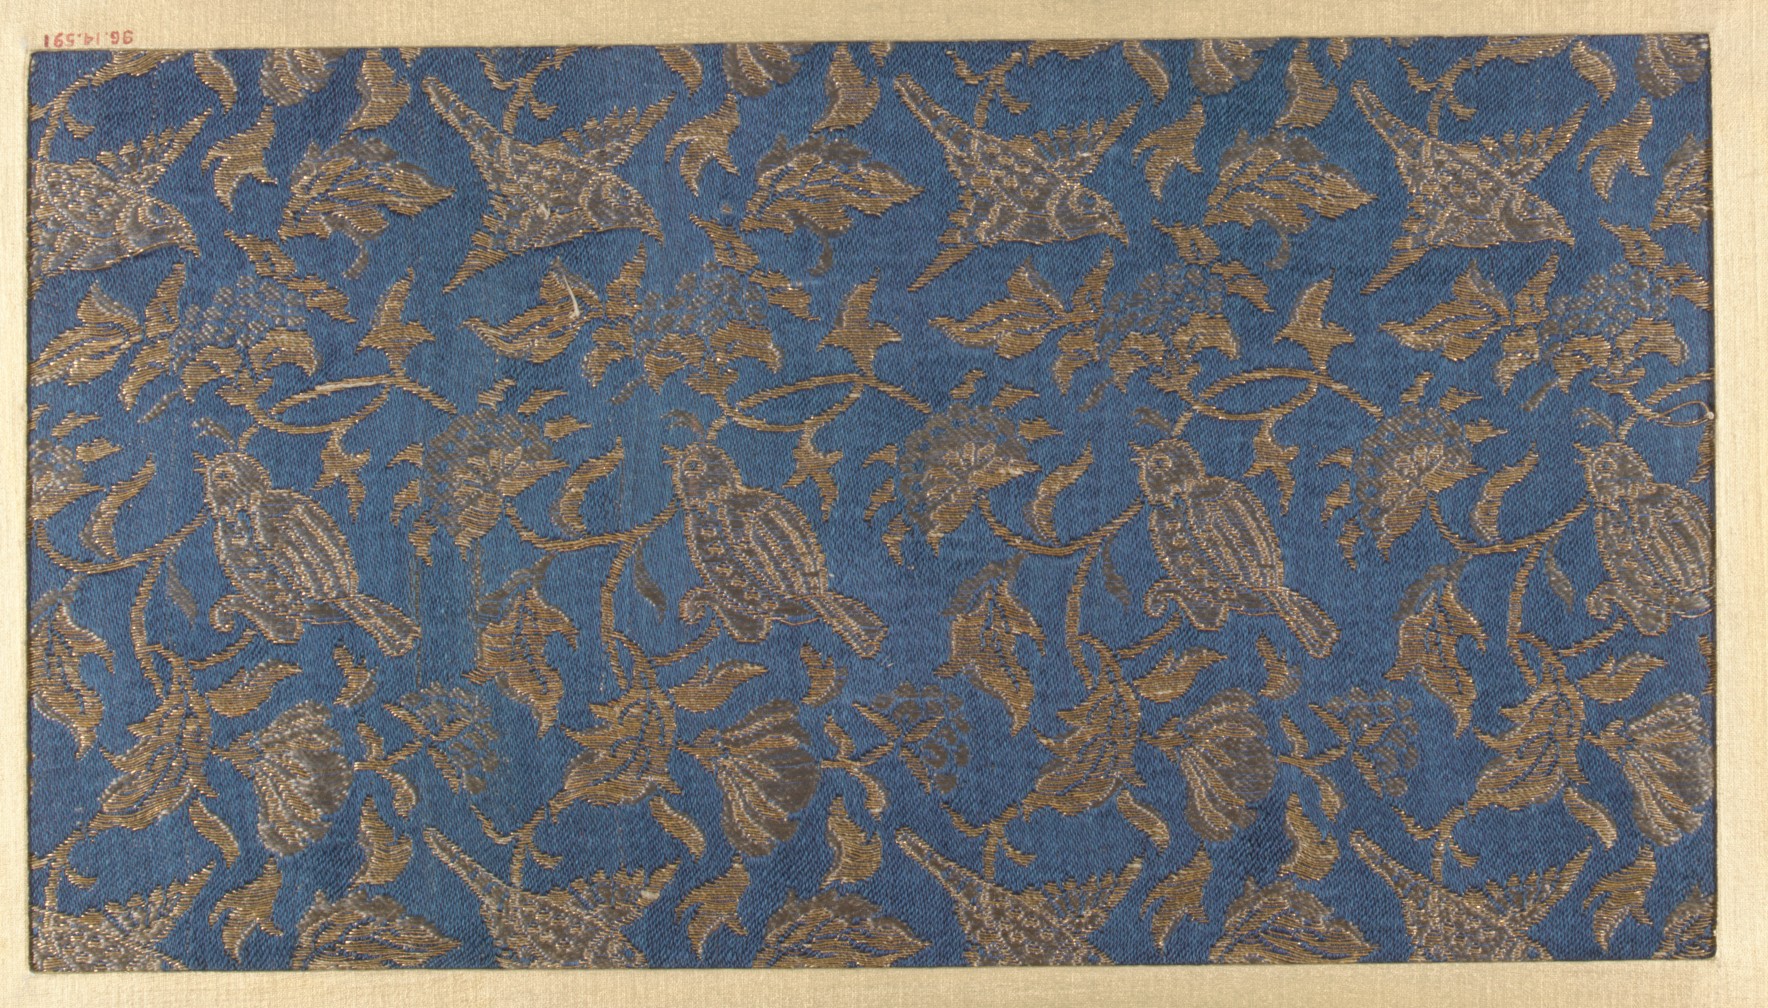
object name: piece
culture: japanese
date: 1701-1900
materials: silk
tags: birds